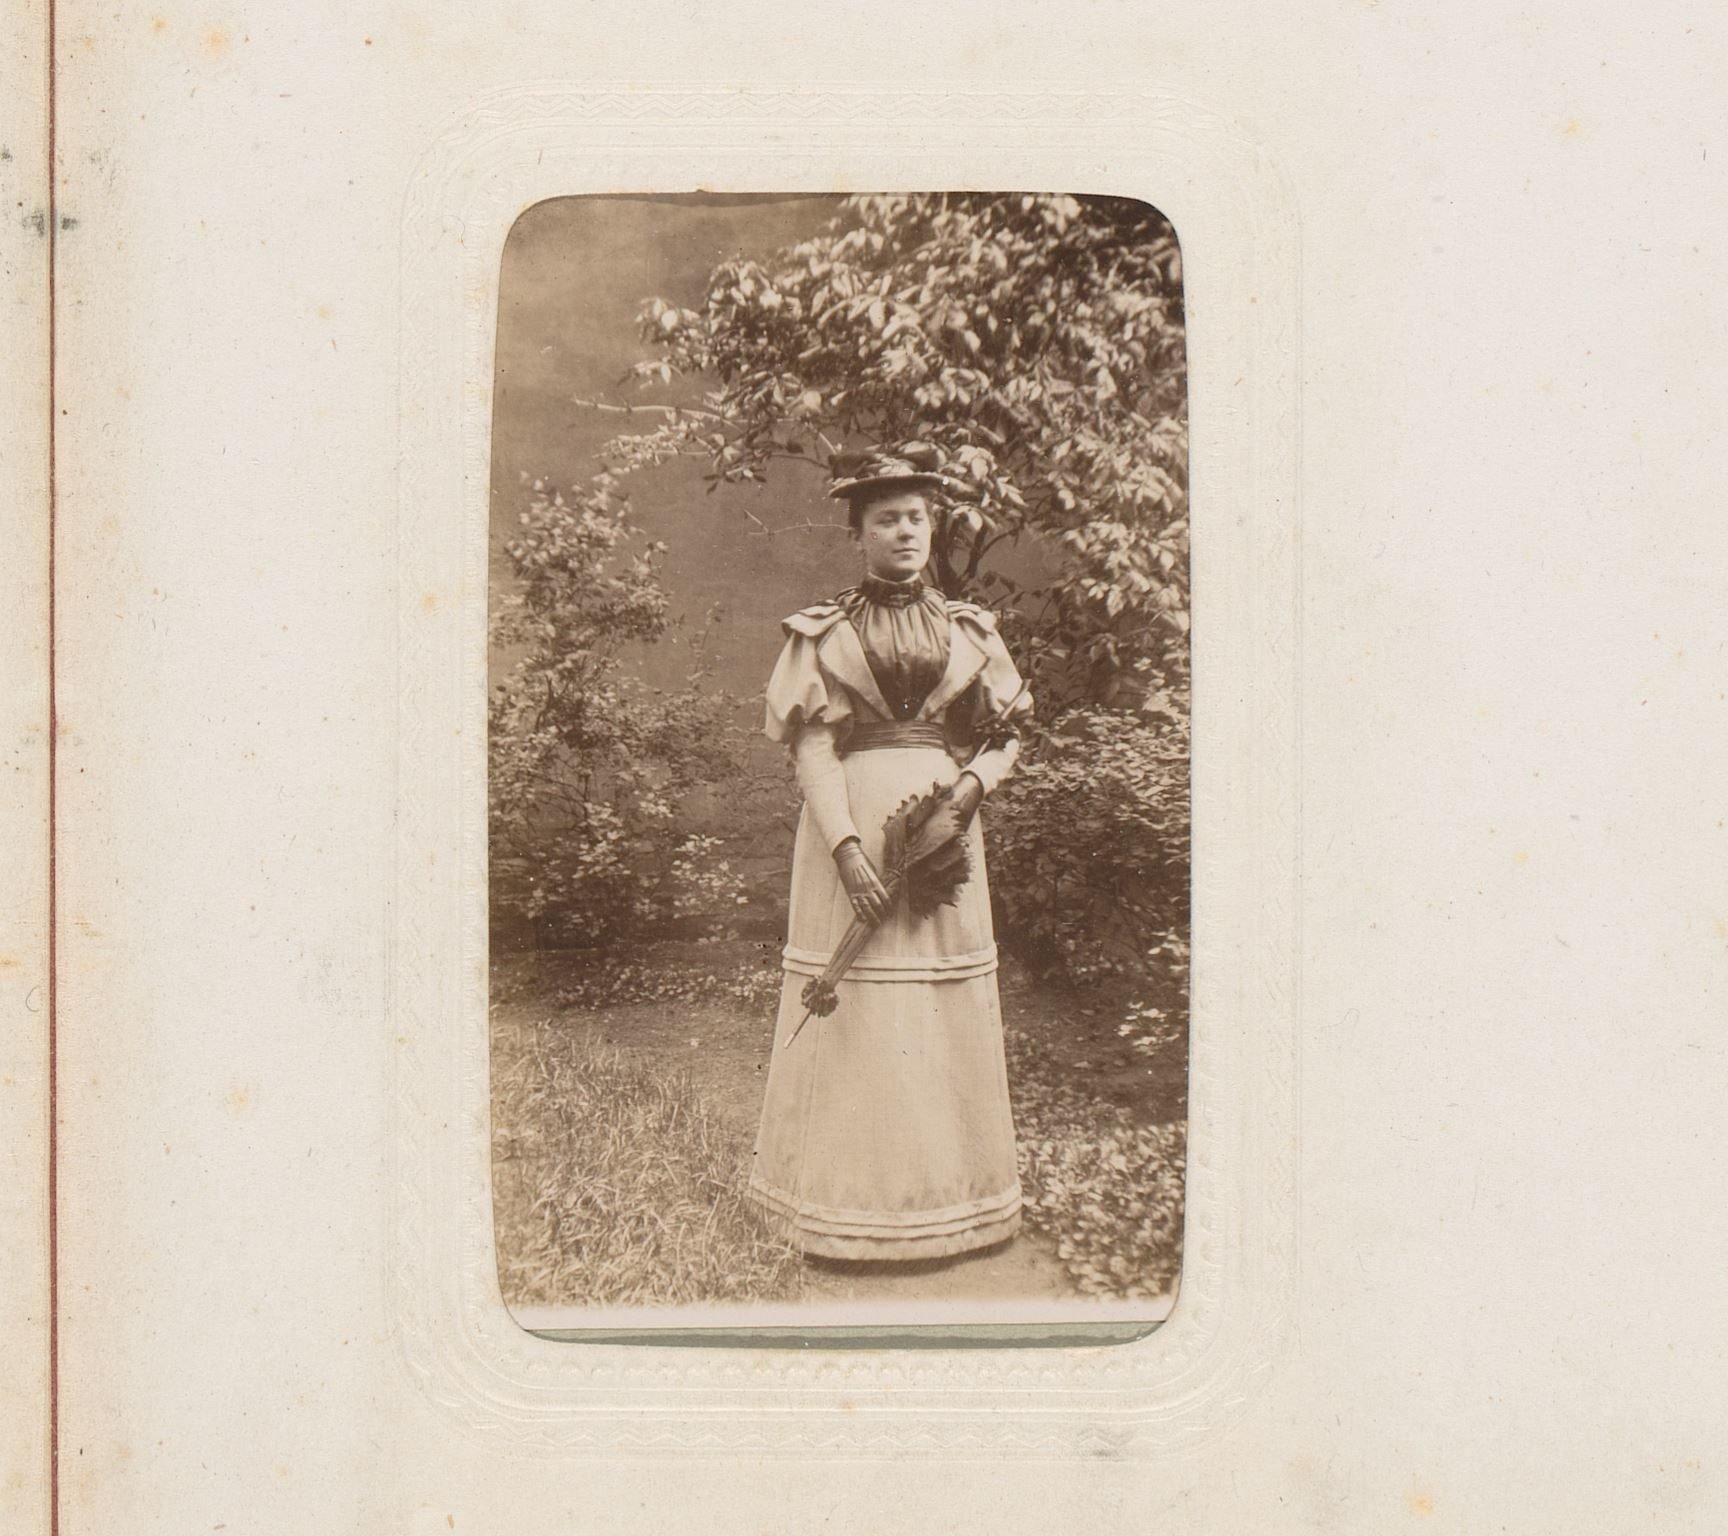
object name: carte de visite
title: Portret van een vrouw met hoed en parasol, staand in een tuin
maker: Anonymous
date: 1894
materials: cardboard, photographic support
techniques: albumen print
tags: historical persons - bb - woman, garden, head-gear: hat, parasol, sunshade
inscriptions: date: ‘7. 5. 94.’